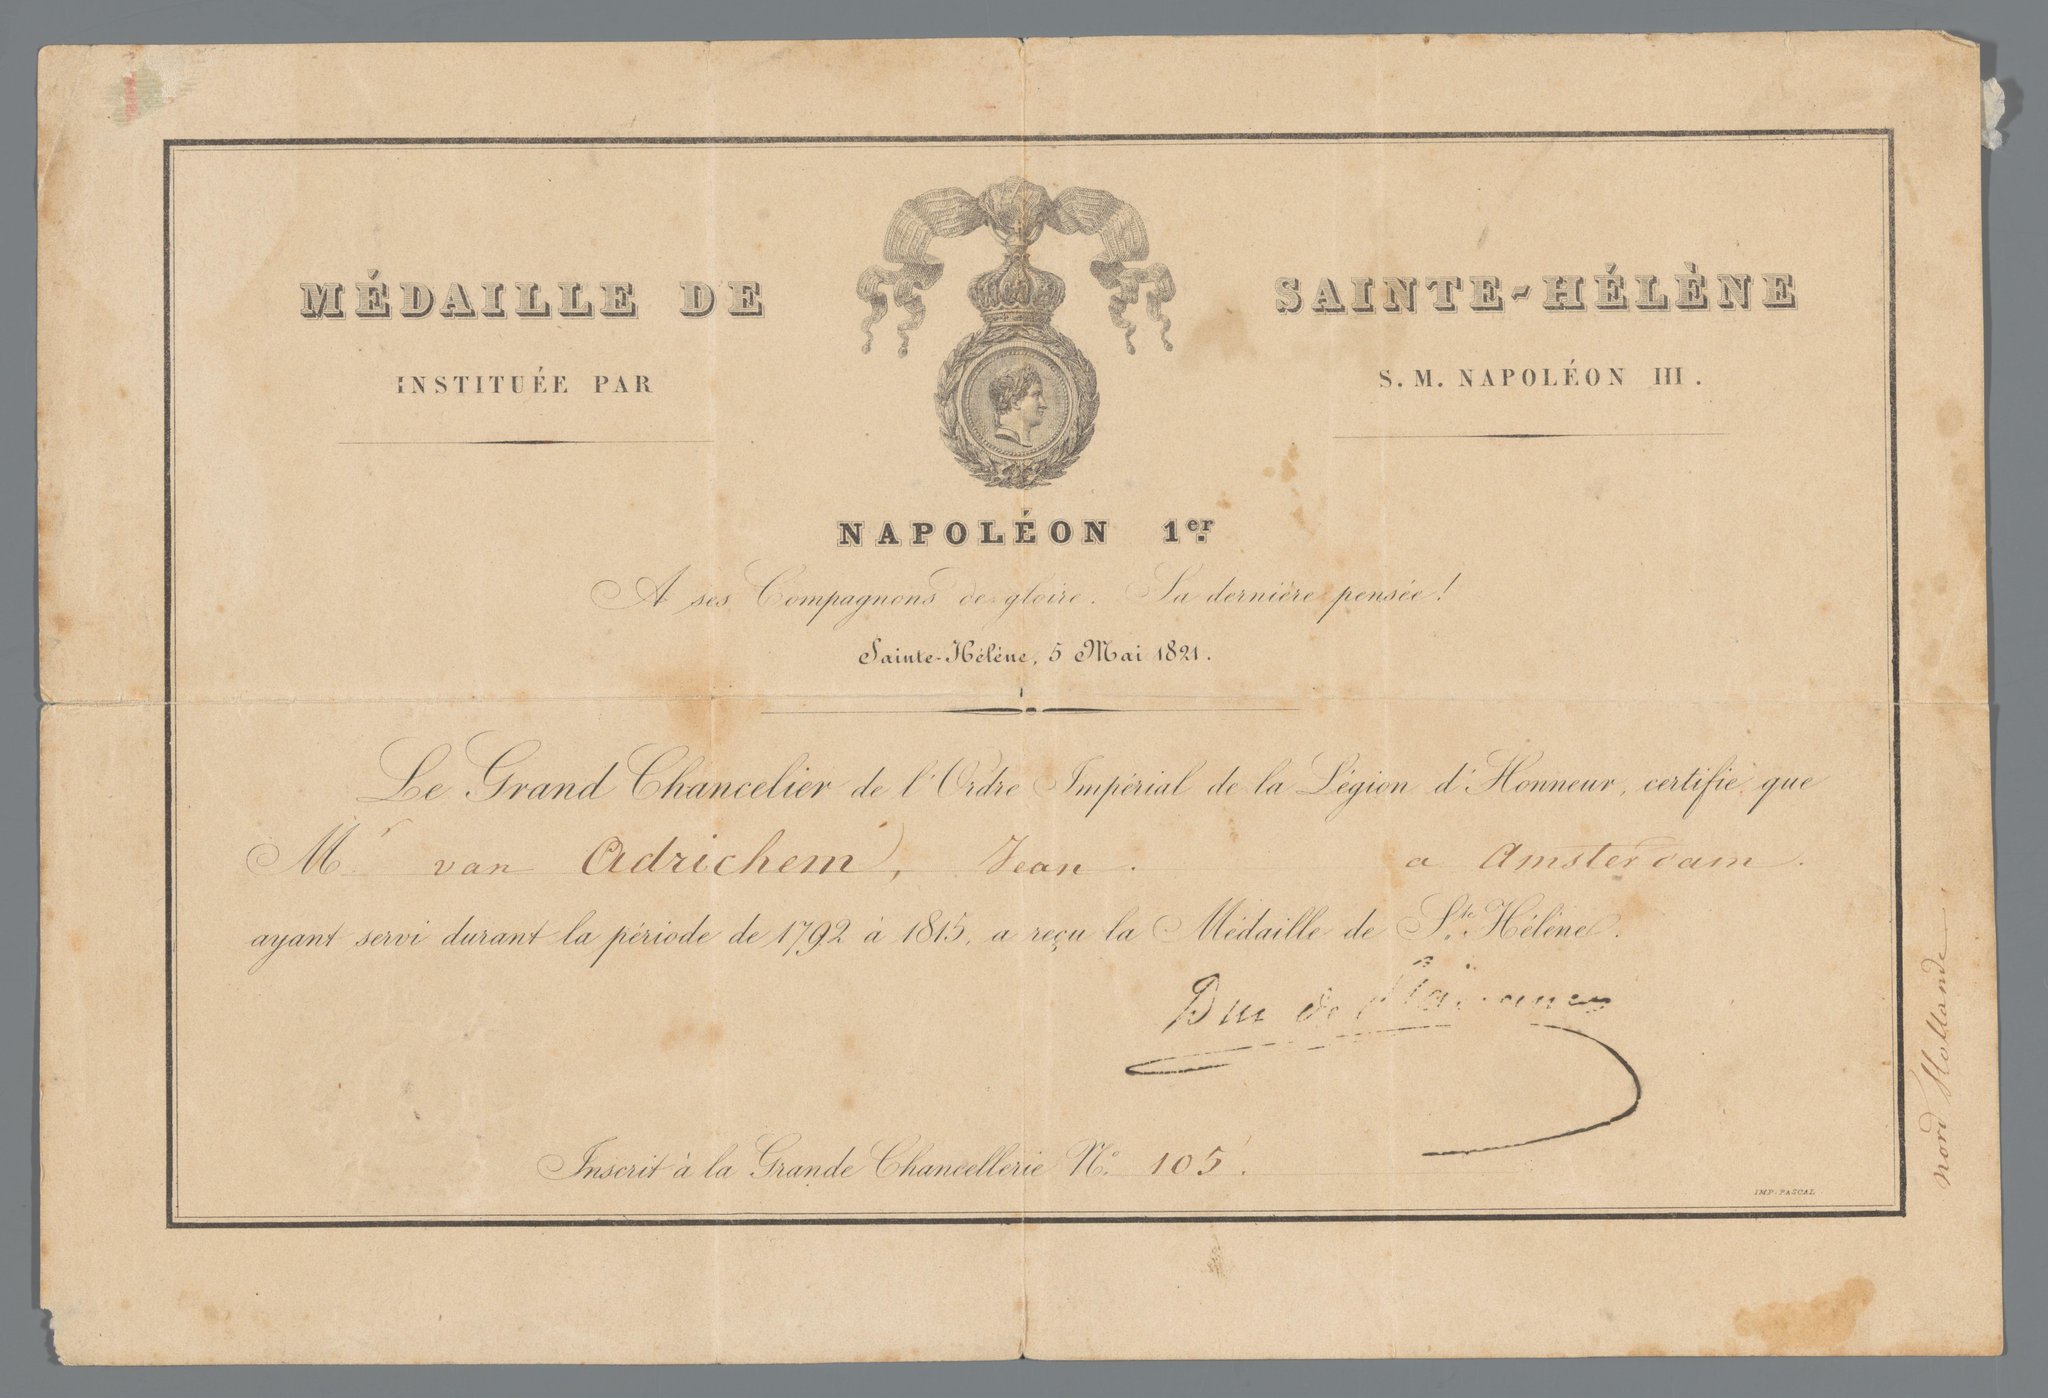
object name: document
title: Médaille de Sainte-Hélène (Sint-Helena)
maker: duc de plaisance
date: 1857-1858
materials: ink, paper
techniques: printing, writing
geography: paris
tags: napoleon i (emperor of the french)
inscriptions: inscription: ‘MEDAILLE DE SAINTE-HELENE INSTITUÉE PAR S.M. NAPOLEON III.’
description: Franstalig document, waarin wordt verklaard dat de heer J. van Adrichem de St-Hélène (Sint Helena) medaille heeft ontvangen vanwege zijn diensttijd tussen 1792 en 1815 in het leger van Napoleon. Eénzijdig bedrukt blad in zwart, tekst in dubbel kader. Tussen titel midden boven: draagteken aan lint van de St. Helena-orde met portret van Napoleon I Bonaparte, keizer der Fransen. Gesigneerd rechtsonder: Duc de Plaisance. Linksonder een reliëfstempel.